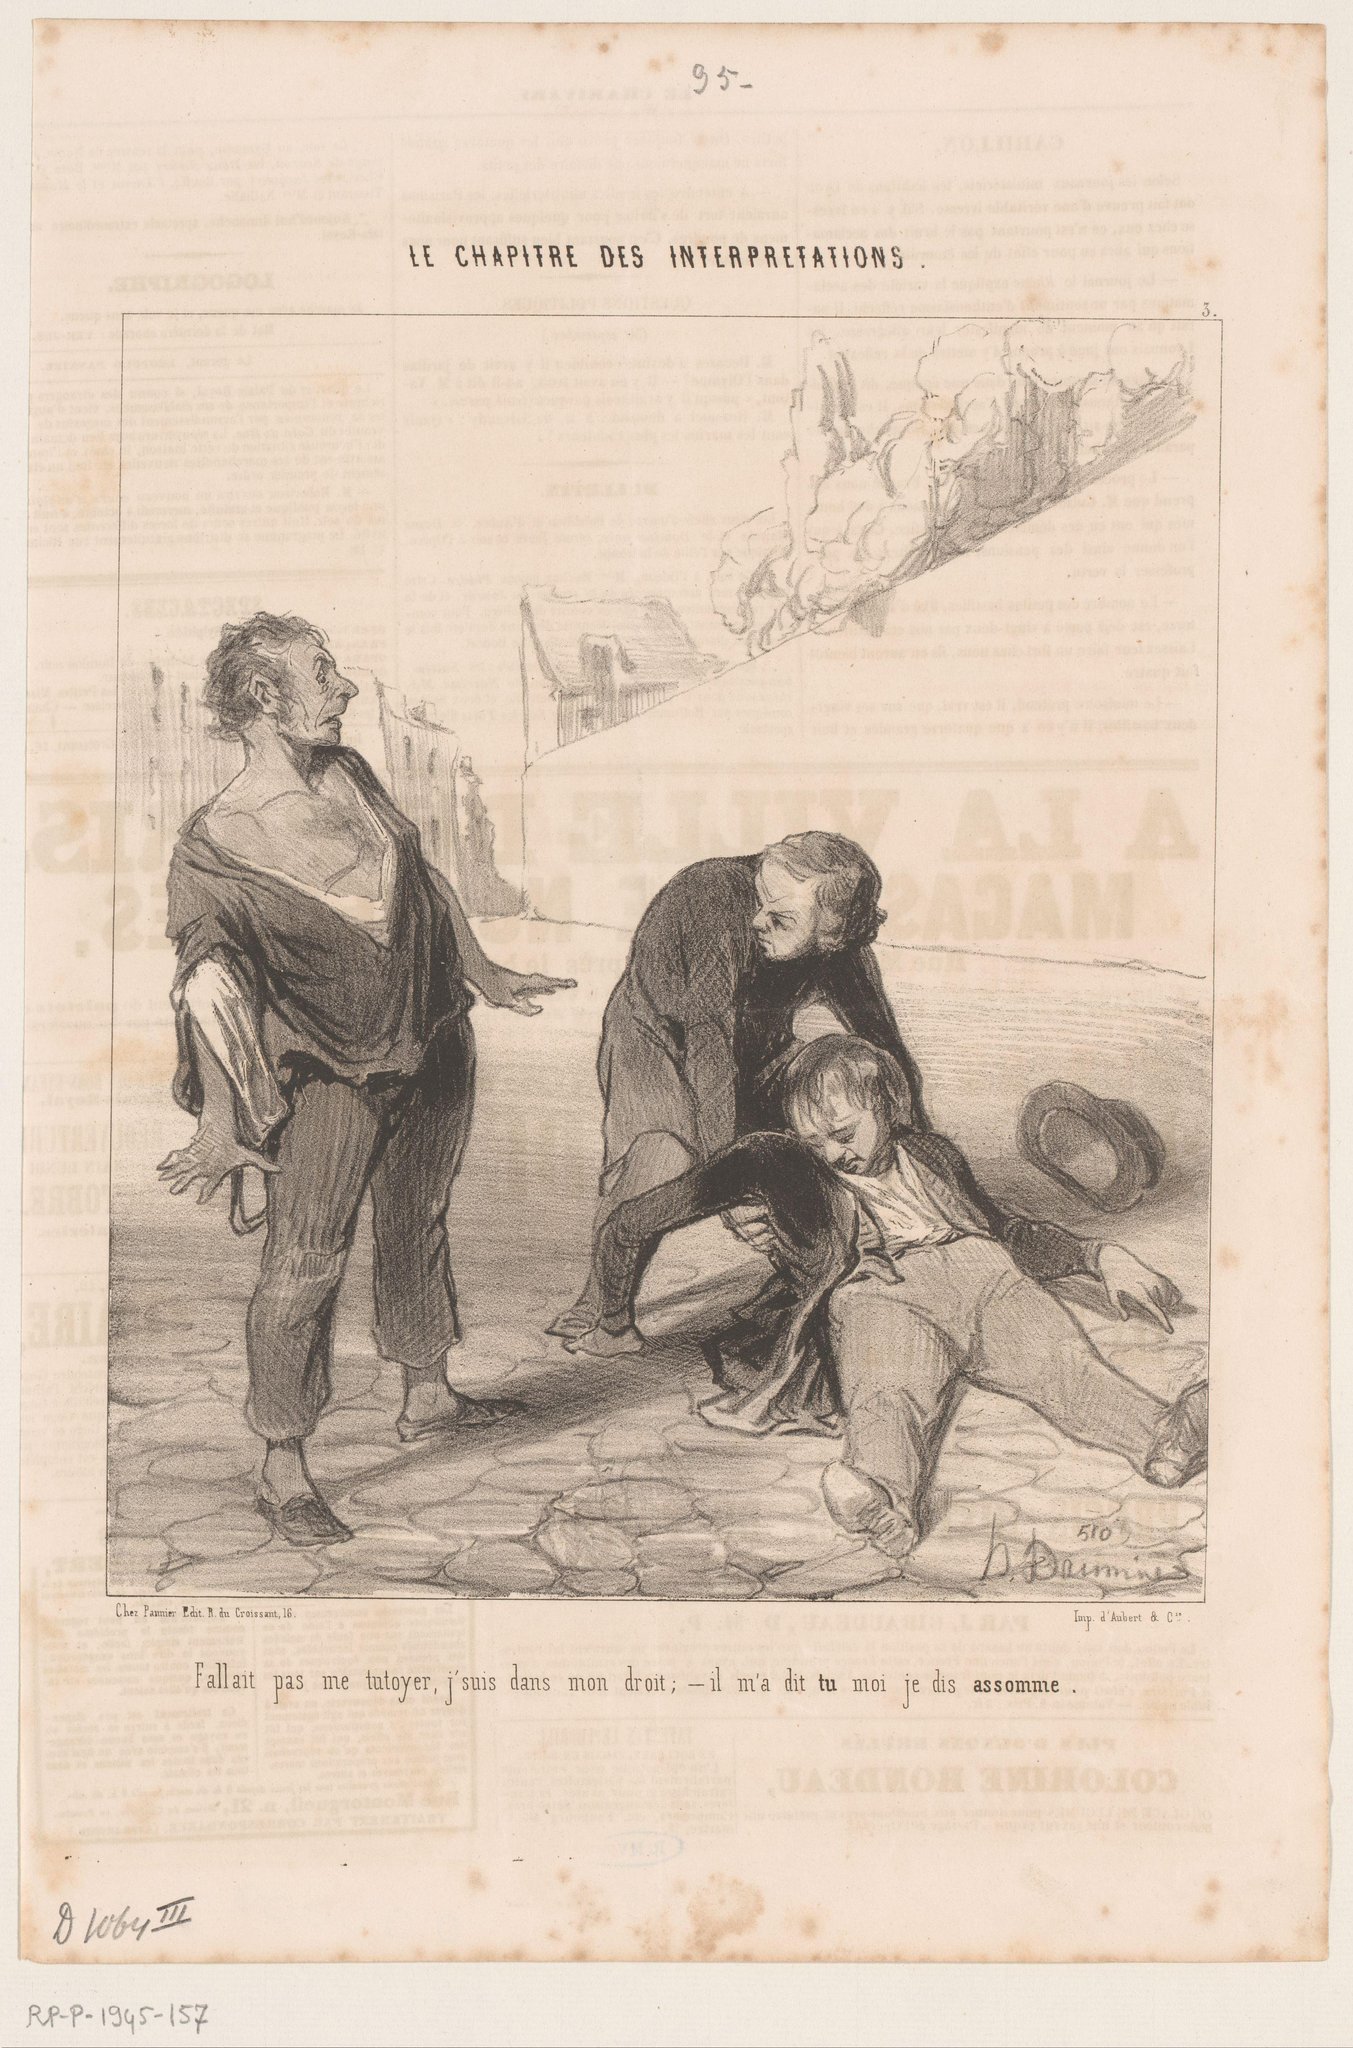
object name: cartoon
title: Fallait pas me tutoyer (...)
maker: honoré daumier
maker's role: draughtsman, painter, print maker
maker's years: 1808-1879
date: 1843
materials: paper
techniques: lithograph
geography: paris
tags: caricatures (human types), linguistic communication, after the street-fight, street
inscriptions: number: ‘95’, collector's mark: Lugt 2228a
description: Prent gepubliceerd in: Le Charivari, Aubert: Parijs, 01-10-1843. Le Charivari was een humoristische krant met karikaturen en (politieke) cartoons.